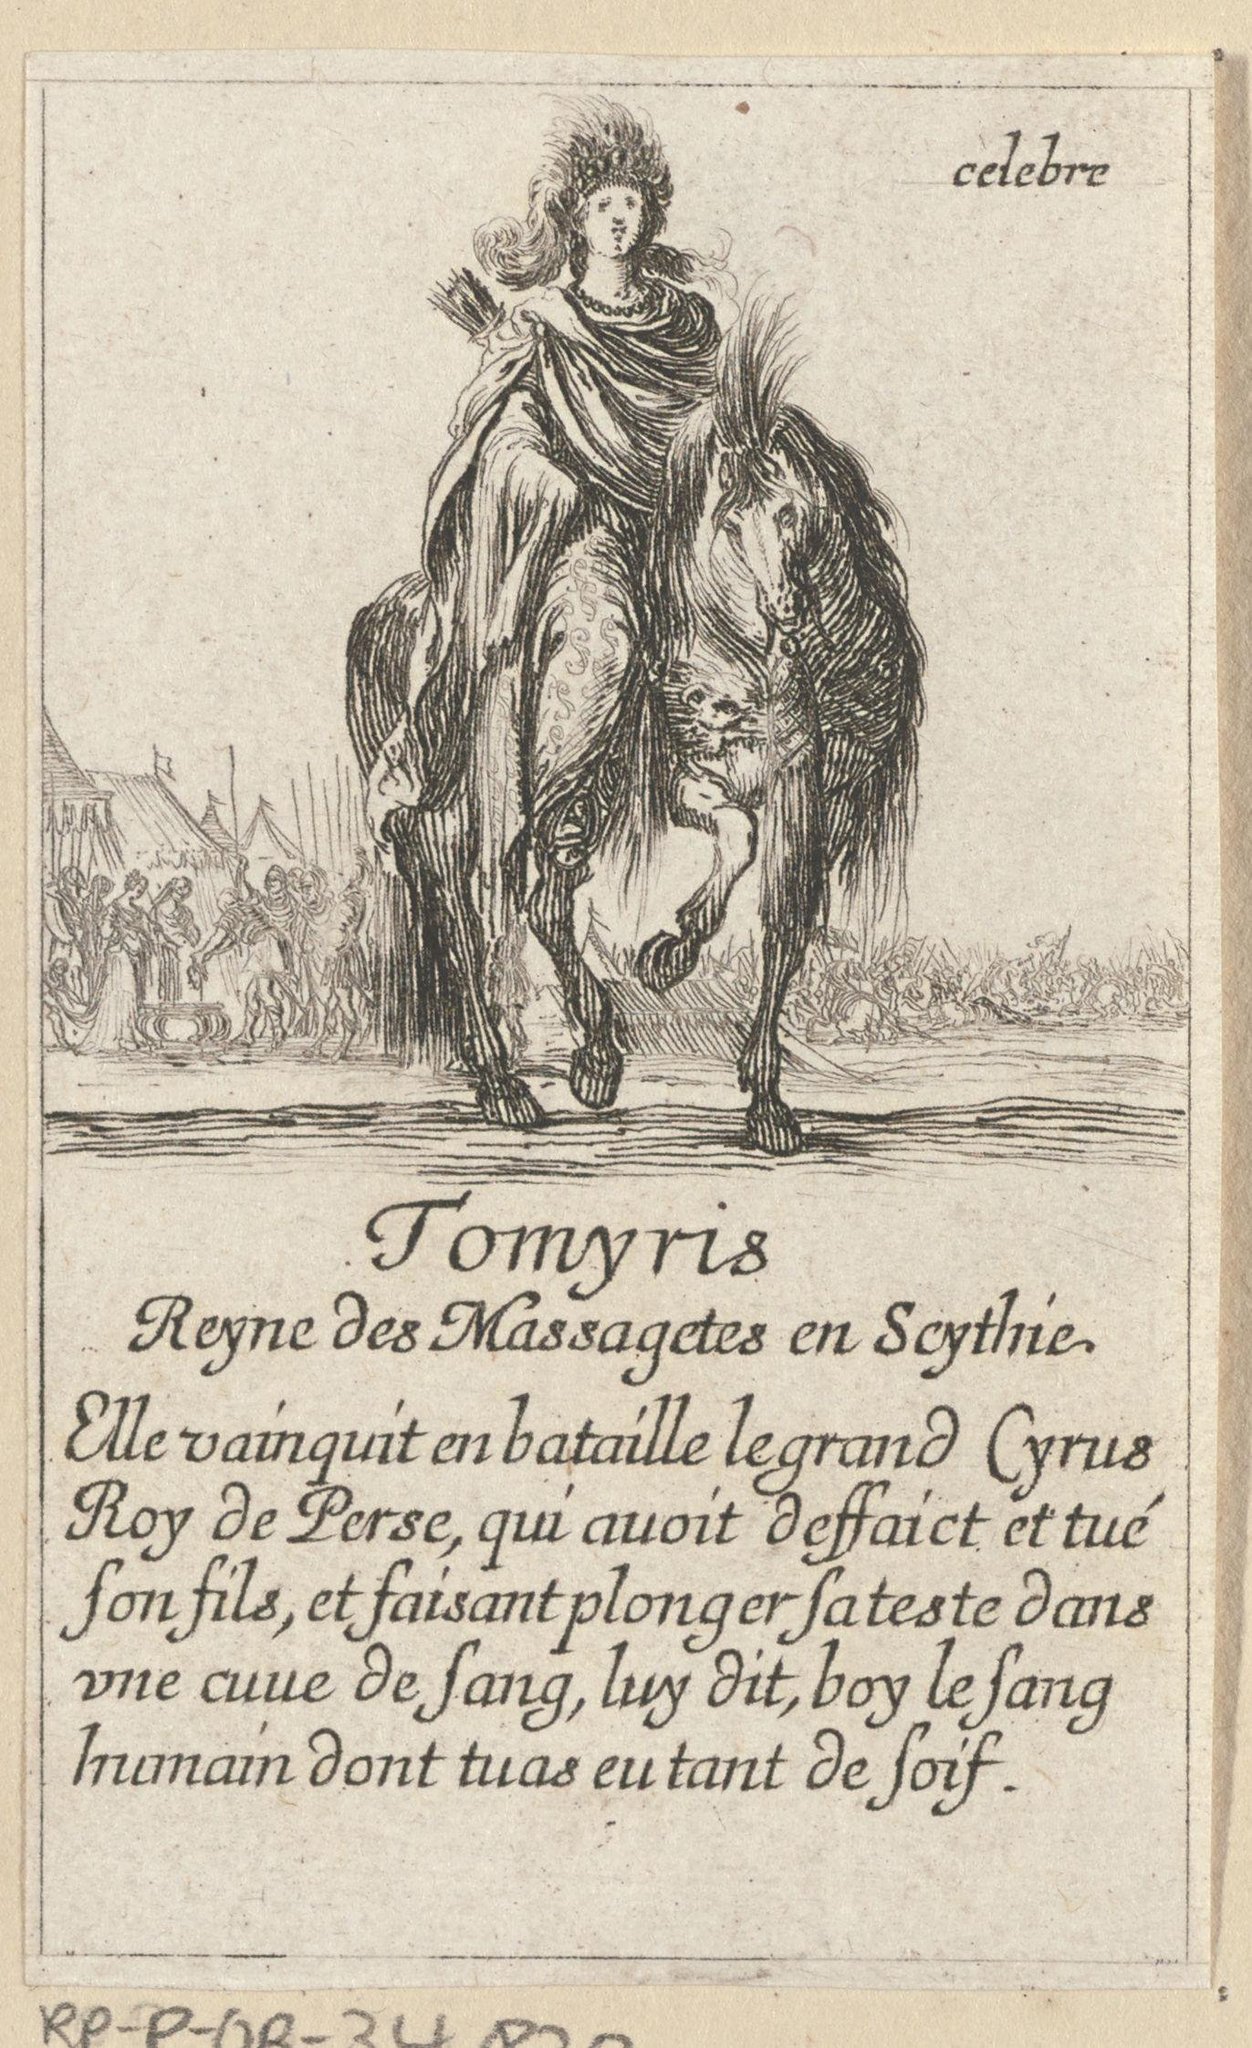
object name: playing card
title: Tomyris Reyne des Massagetes en Scythie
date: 1620-1664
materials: paper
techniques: etching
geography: paris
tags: riding a horse, ass, or mule; rider, horseman, (story of) tomyris, ruler, sovereign - bb - female ruler, horse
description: Deze prent maakt deel uit van een kaartspel met 52 kaarten met voorstellingen van beroemde koninginnen. De serie is uitgedacht door Jean Desmarests de Saint-Sorlin in opdracht van Kardinaal Mazarin. Het kaartspel werd gemaakt voor de jonge Lodewijk XIV, samen met het Jeu des Fables, Jeu de la Géographie en Jeu des Rois de France.